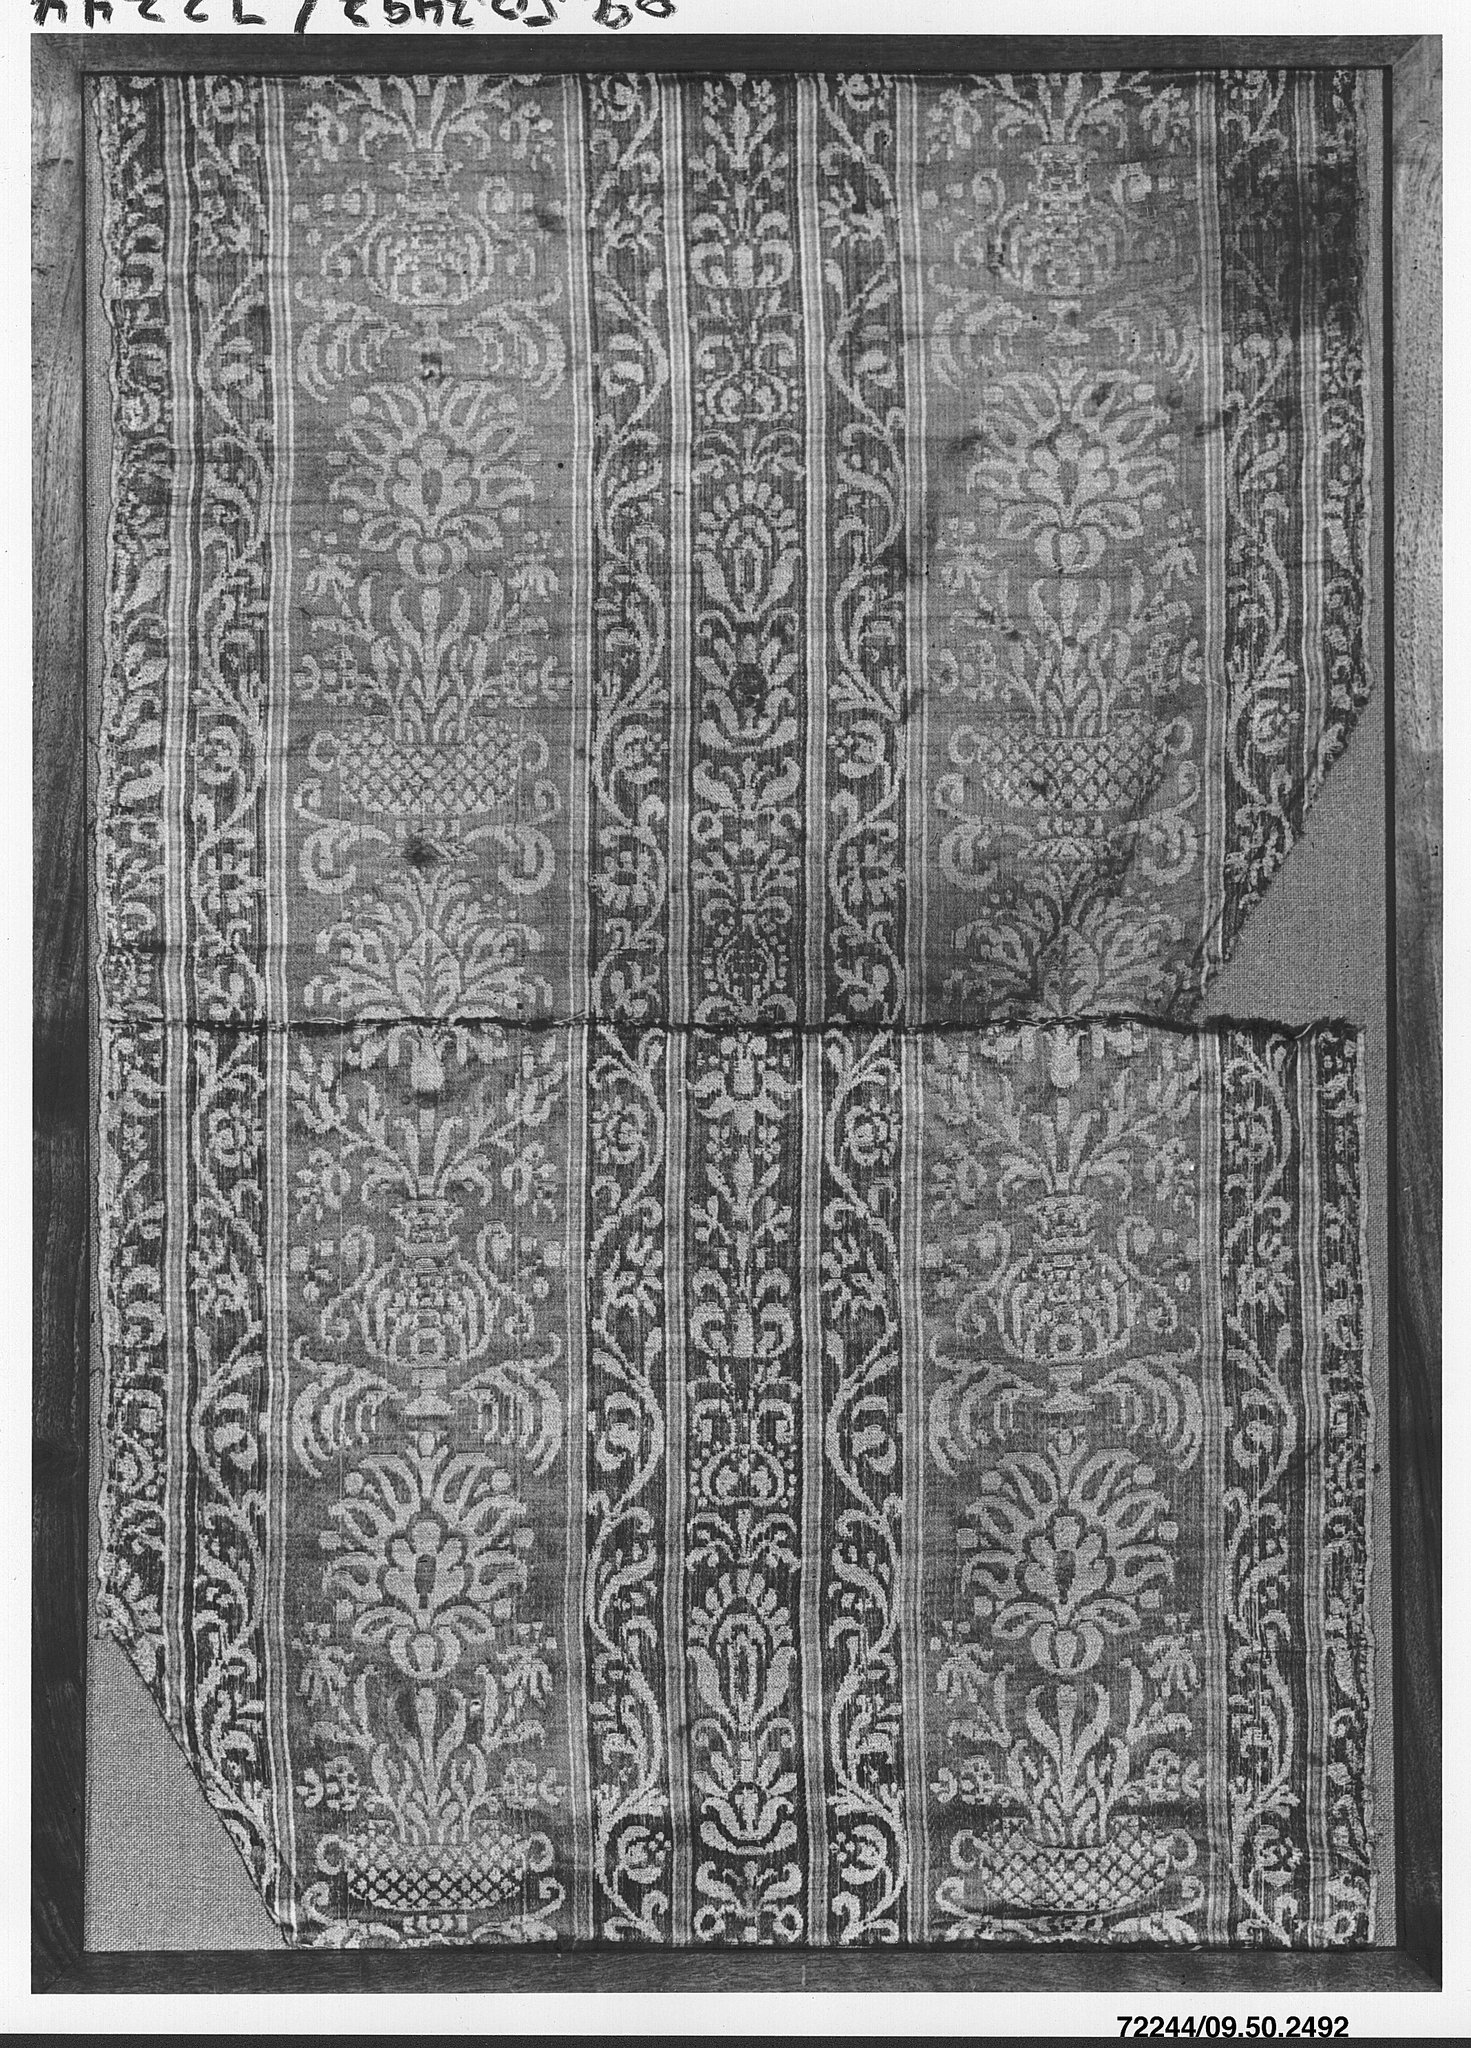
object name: fragment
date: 1501-1600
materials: linen, silk